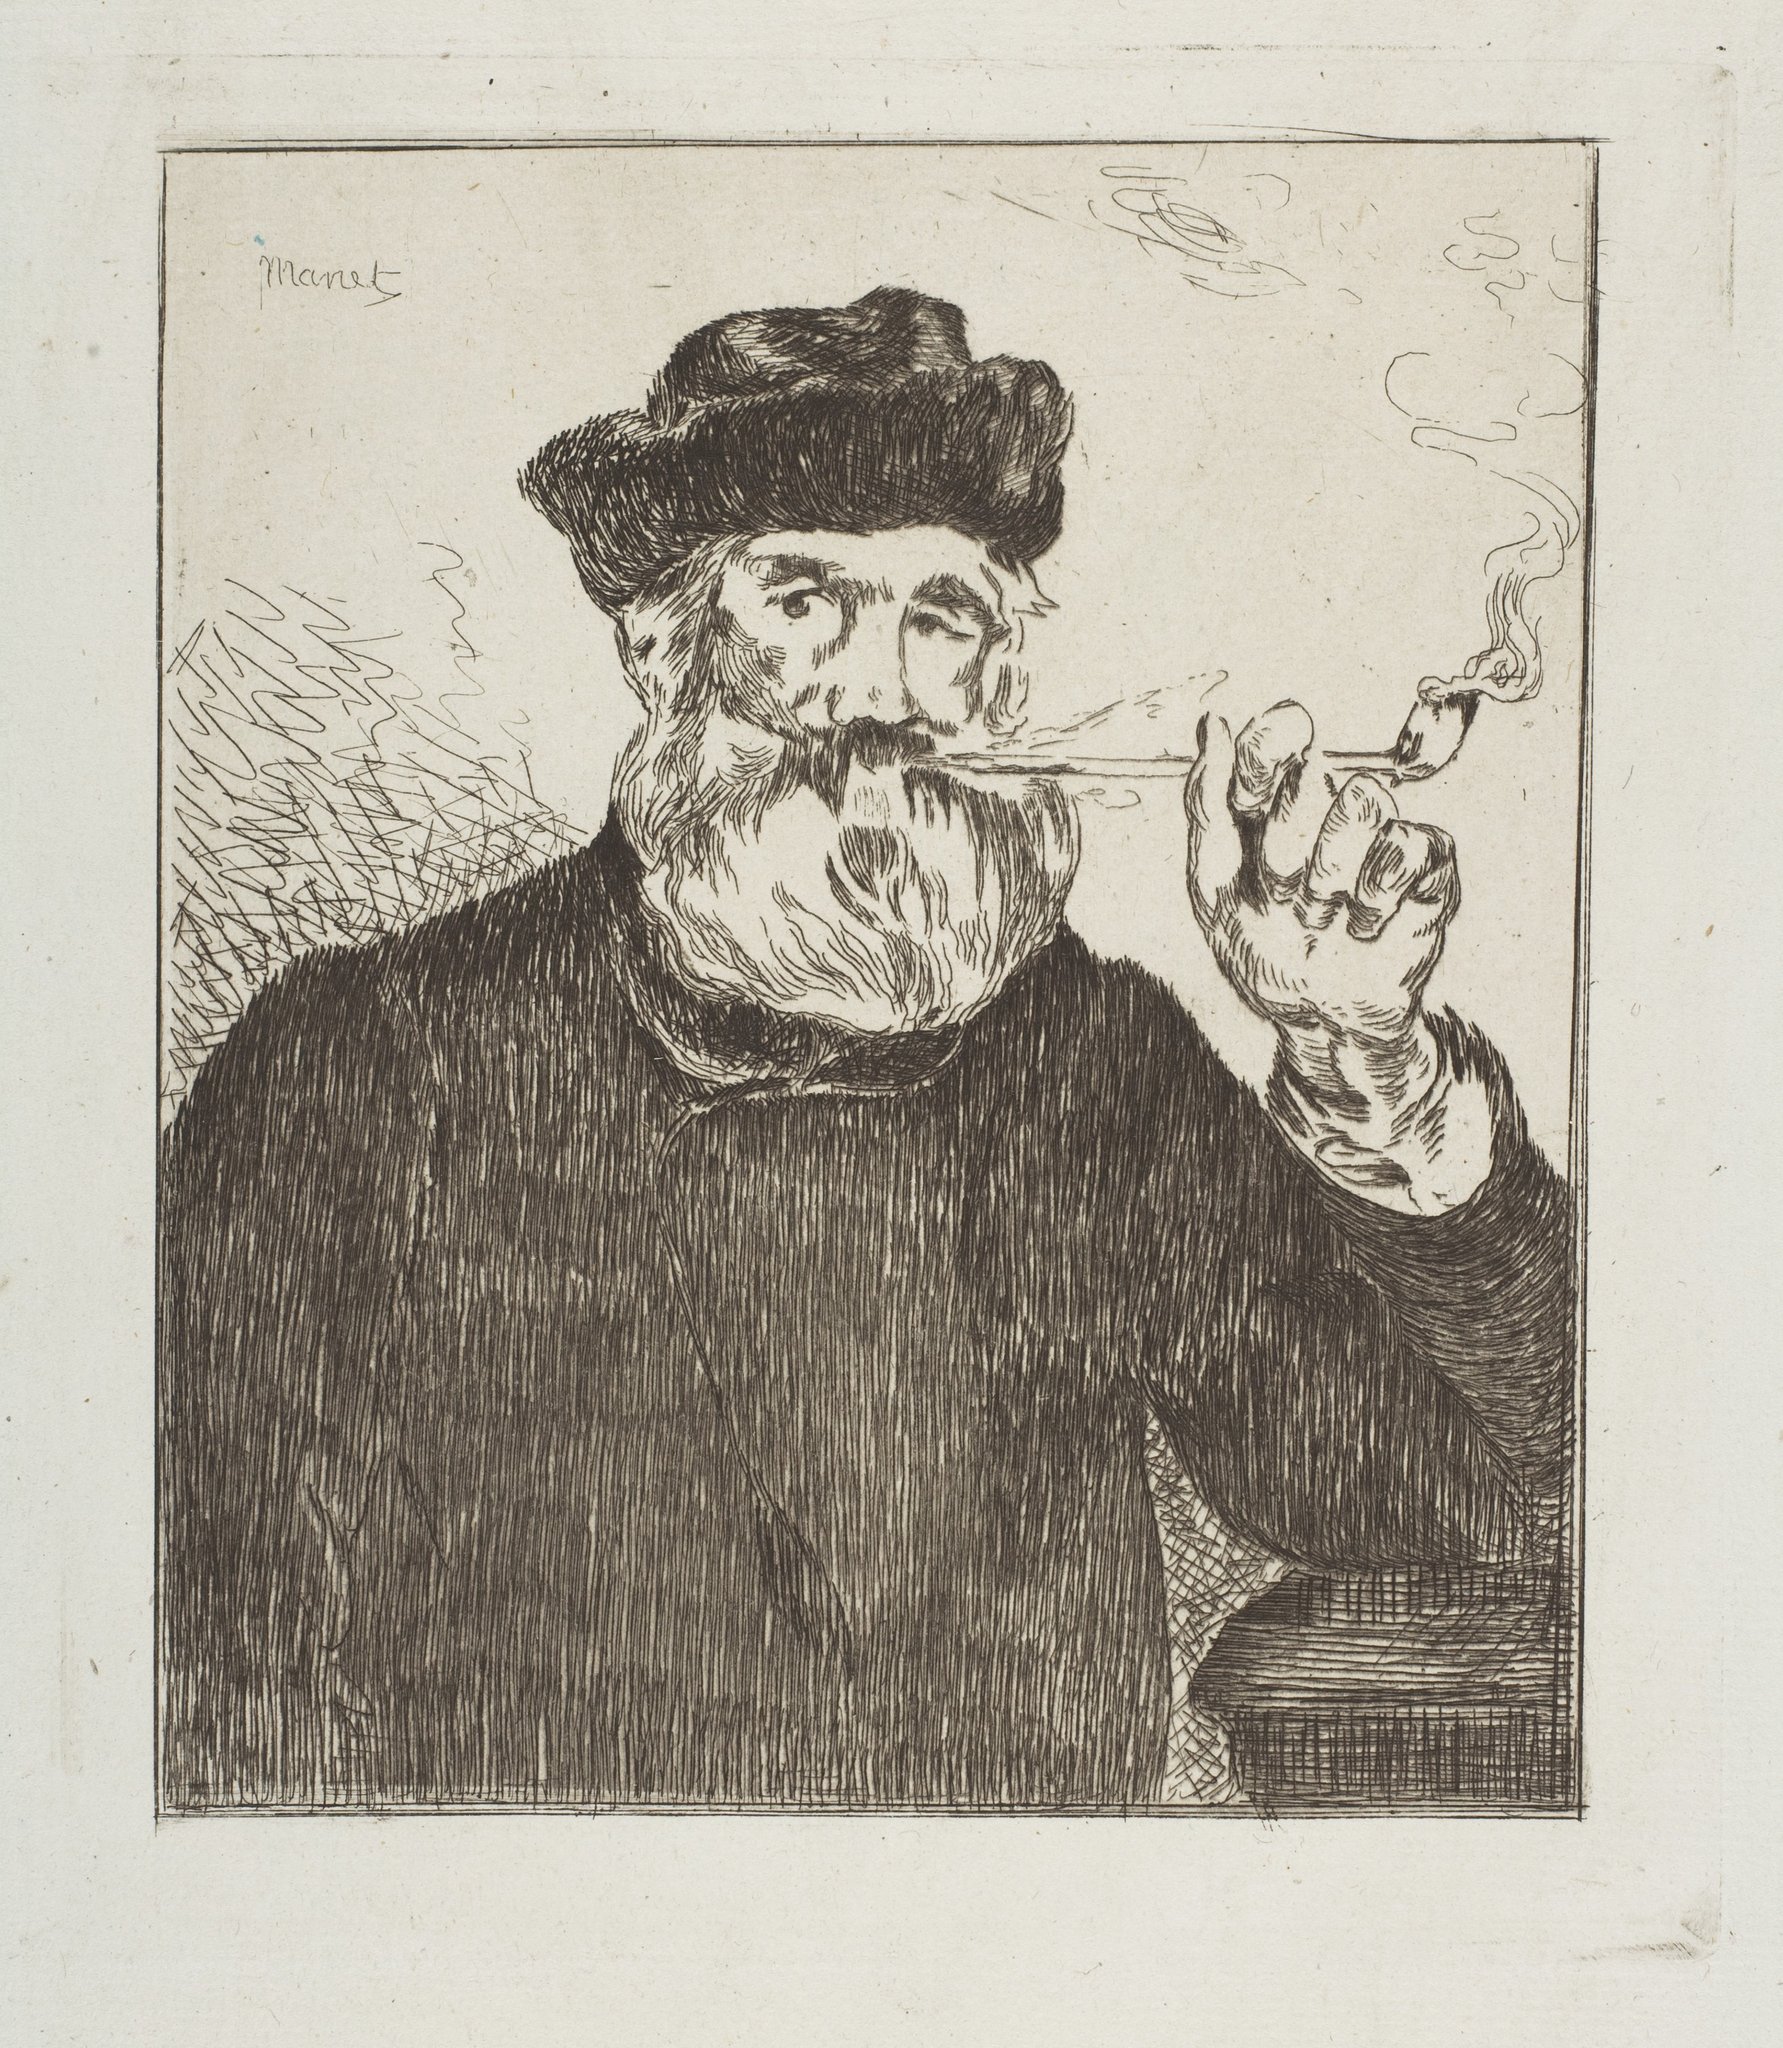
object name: print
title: The Smoker (Le Fumeur)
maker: édouard manet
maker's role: artist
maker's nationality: french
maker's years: 1832-1883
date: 1866-1867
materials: paper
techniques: etching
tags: men,smoking